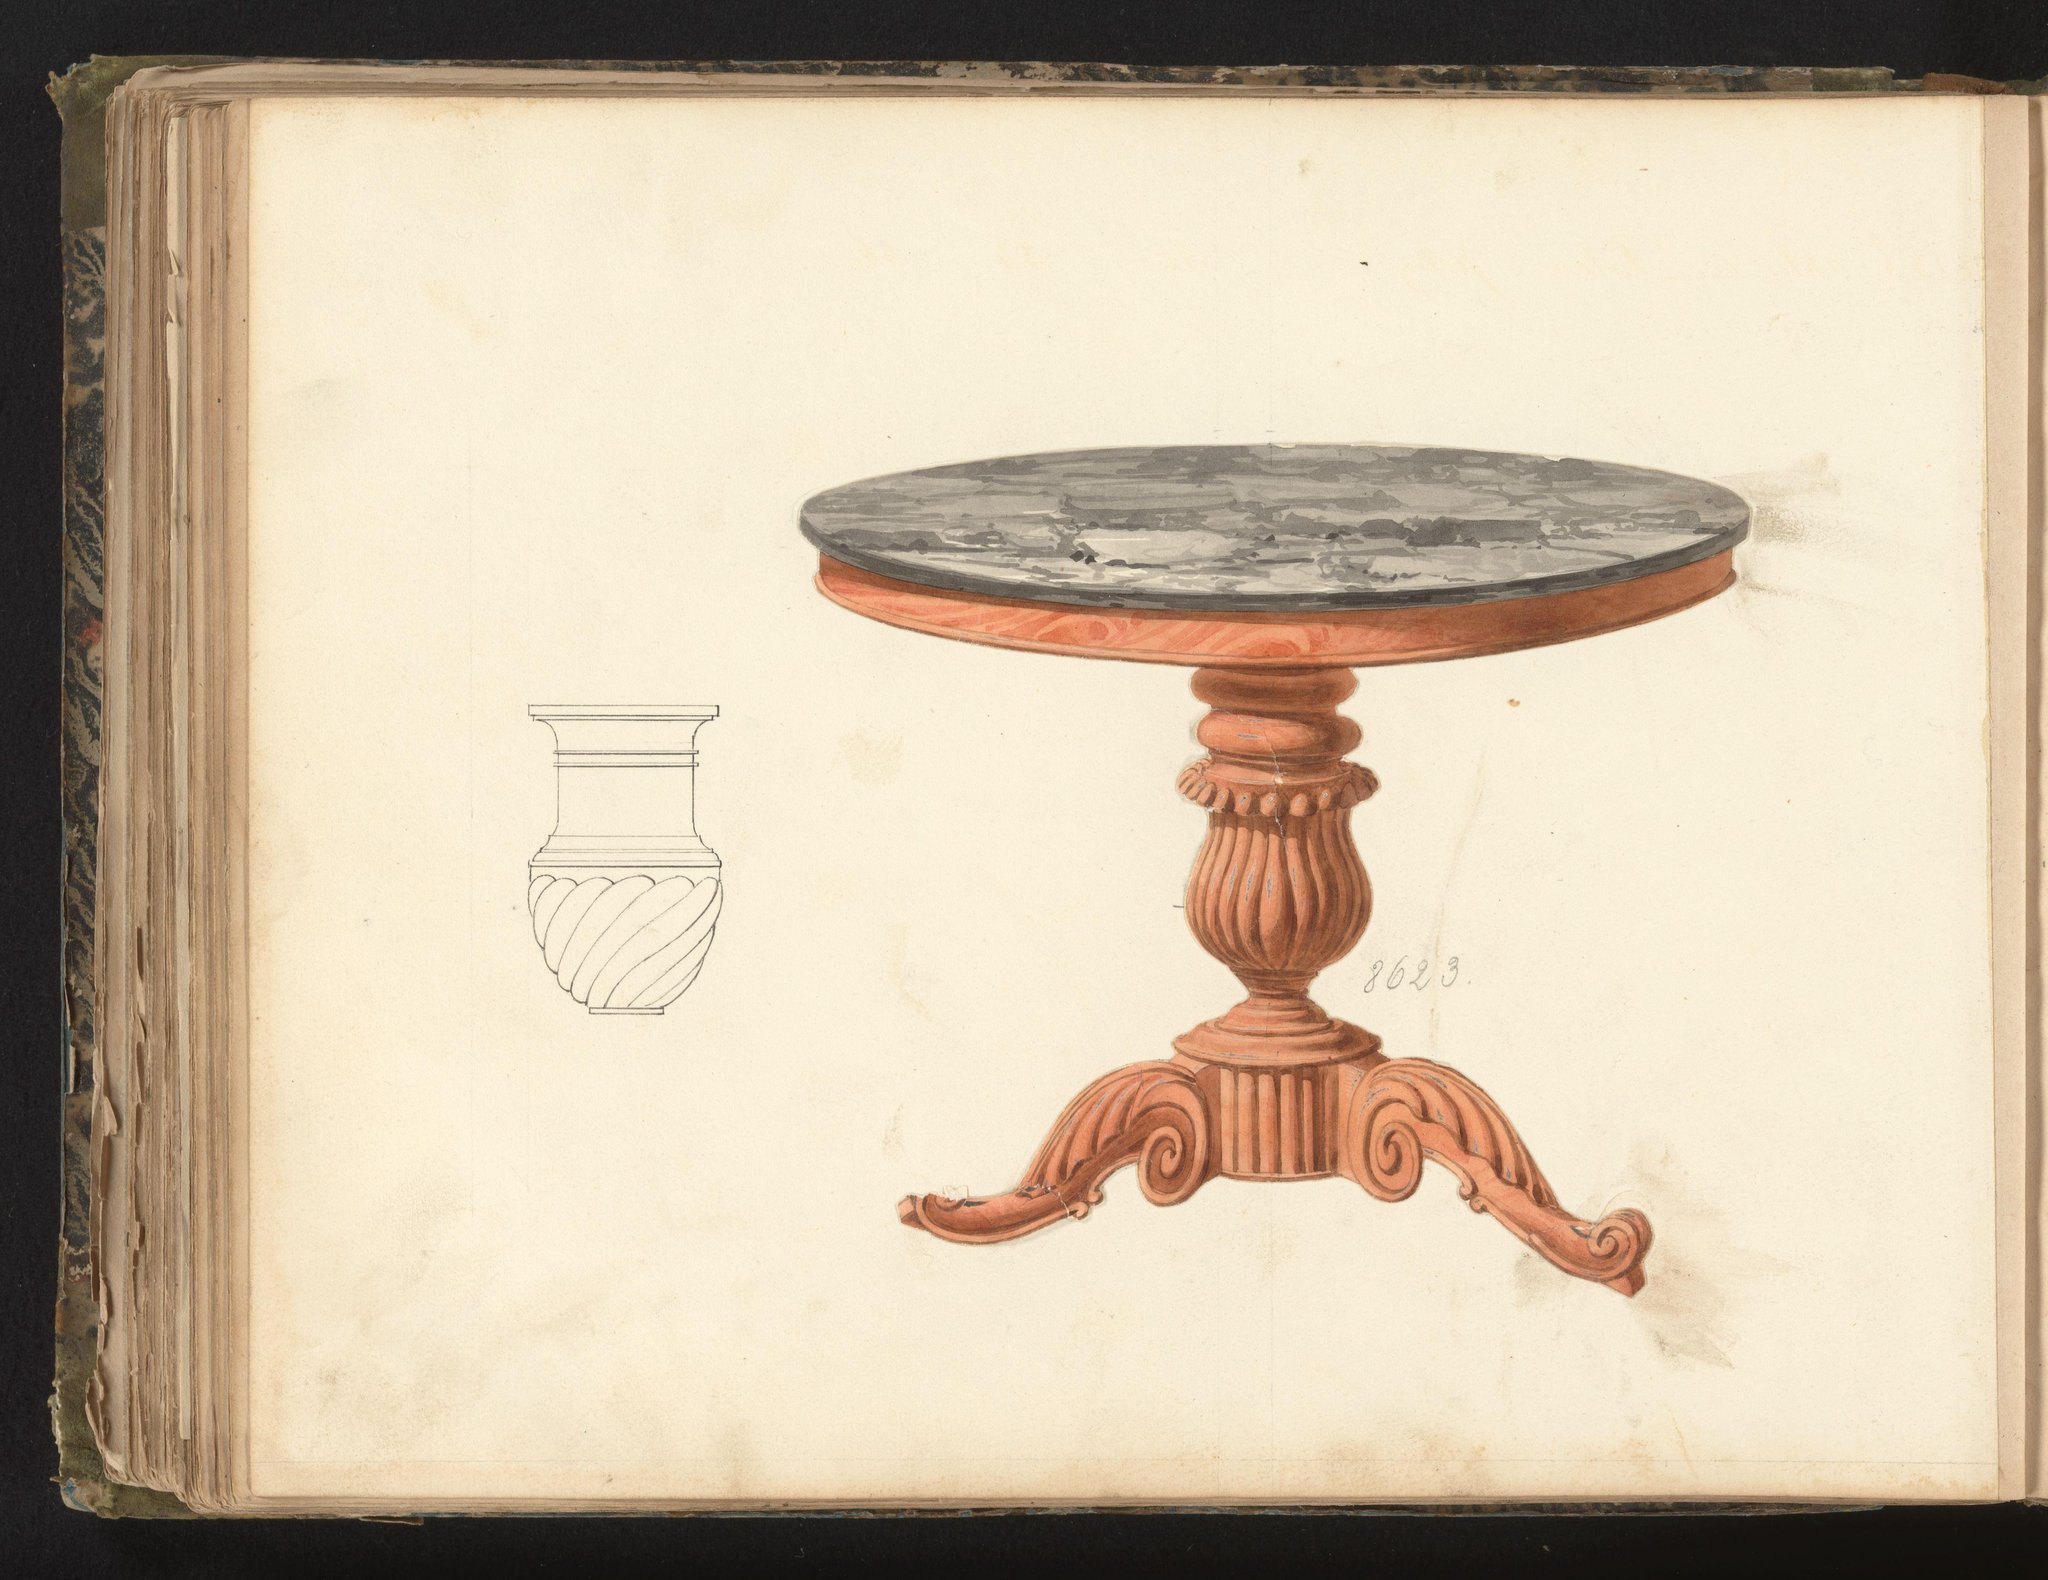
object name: drawing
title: Ontwerp voor een tafel en tekening van een vaasvormige verbinding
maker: Anonymous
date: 1825-1839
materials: ink, paper, pencil, watercolor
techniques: brush, pen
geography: paris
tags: table (+ wood and other phytogenic material), furniture to put things on (+ stone)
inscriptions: inscription: ‘8623 Table de salon a patin 30 33 36’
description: Ontwerp voor een tafel met gebeeldhouwde voet in mahoniehout en rond marmeren blad (salontafel), met een tekening in potlood (met liniaal) van een vaasvormige verbinding. Het blad op de achterzijde genummerd: 54, het tegenoverliggende blad met informatie over de afgebeelde meubelen genummerd: 54 bis. Onderdeel van een album met 80 bladen met tekeningen en een prent van gefineerde en gelakte meubelen, alsmede zitmeubelen.